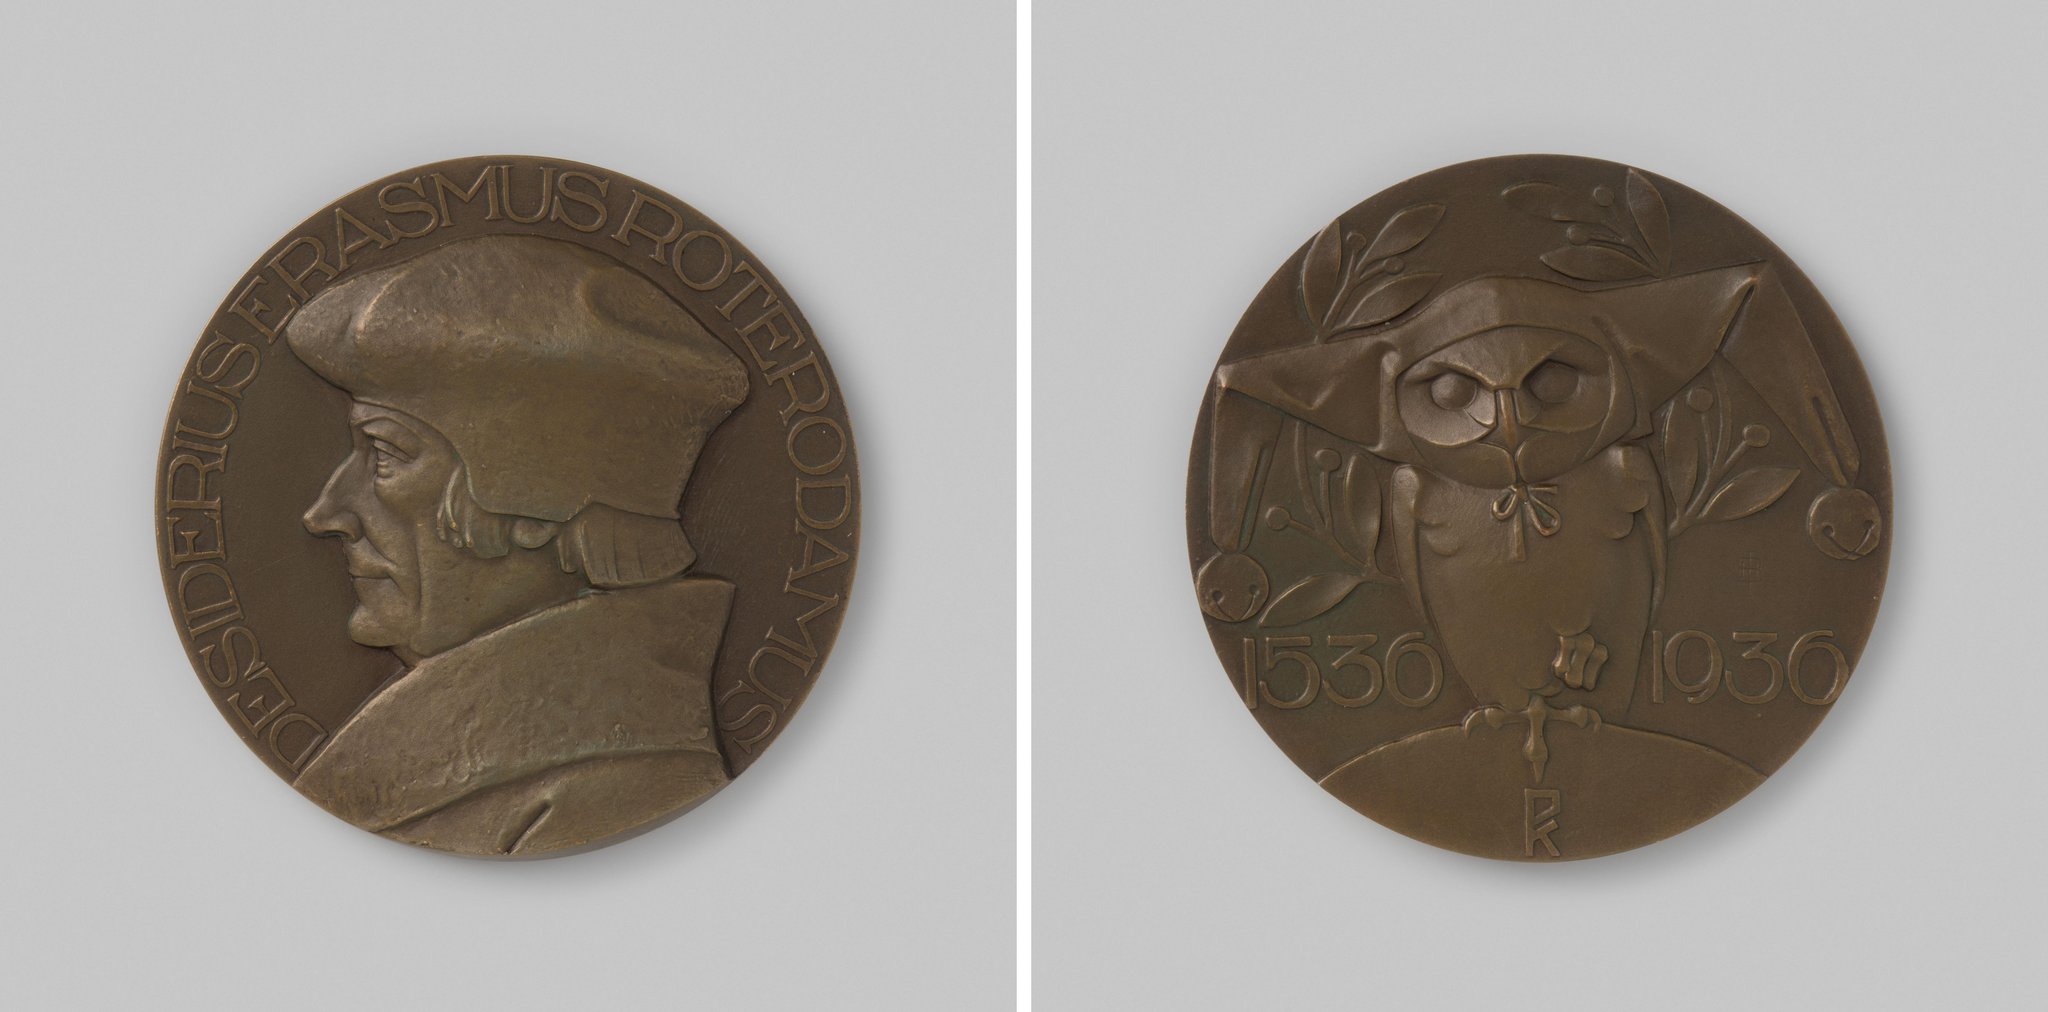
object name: history medal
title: Desiderius Erasmus vierhonderd jaar overleden (Vereniging voor Penningkunst 1936, eerste penning)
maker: bon ingenhousz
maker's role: print maker, sculptor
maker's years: 1881-1953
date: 1936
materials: bronze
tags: desiderius erasmus, rotterdam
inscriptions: : ‘DESIDERIUS ERASMUS ROTERODAMUS’, date: ‘1536 1936’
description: Bronzen penning. Voorzijde: portret van Erasmus met omschrift. Keerzijde: uil met narrenkap met datering. Gemerkt.